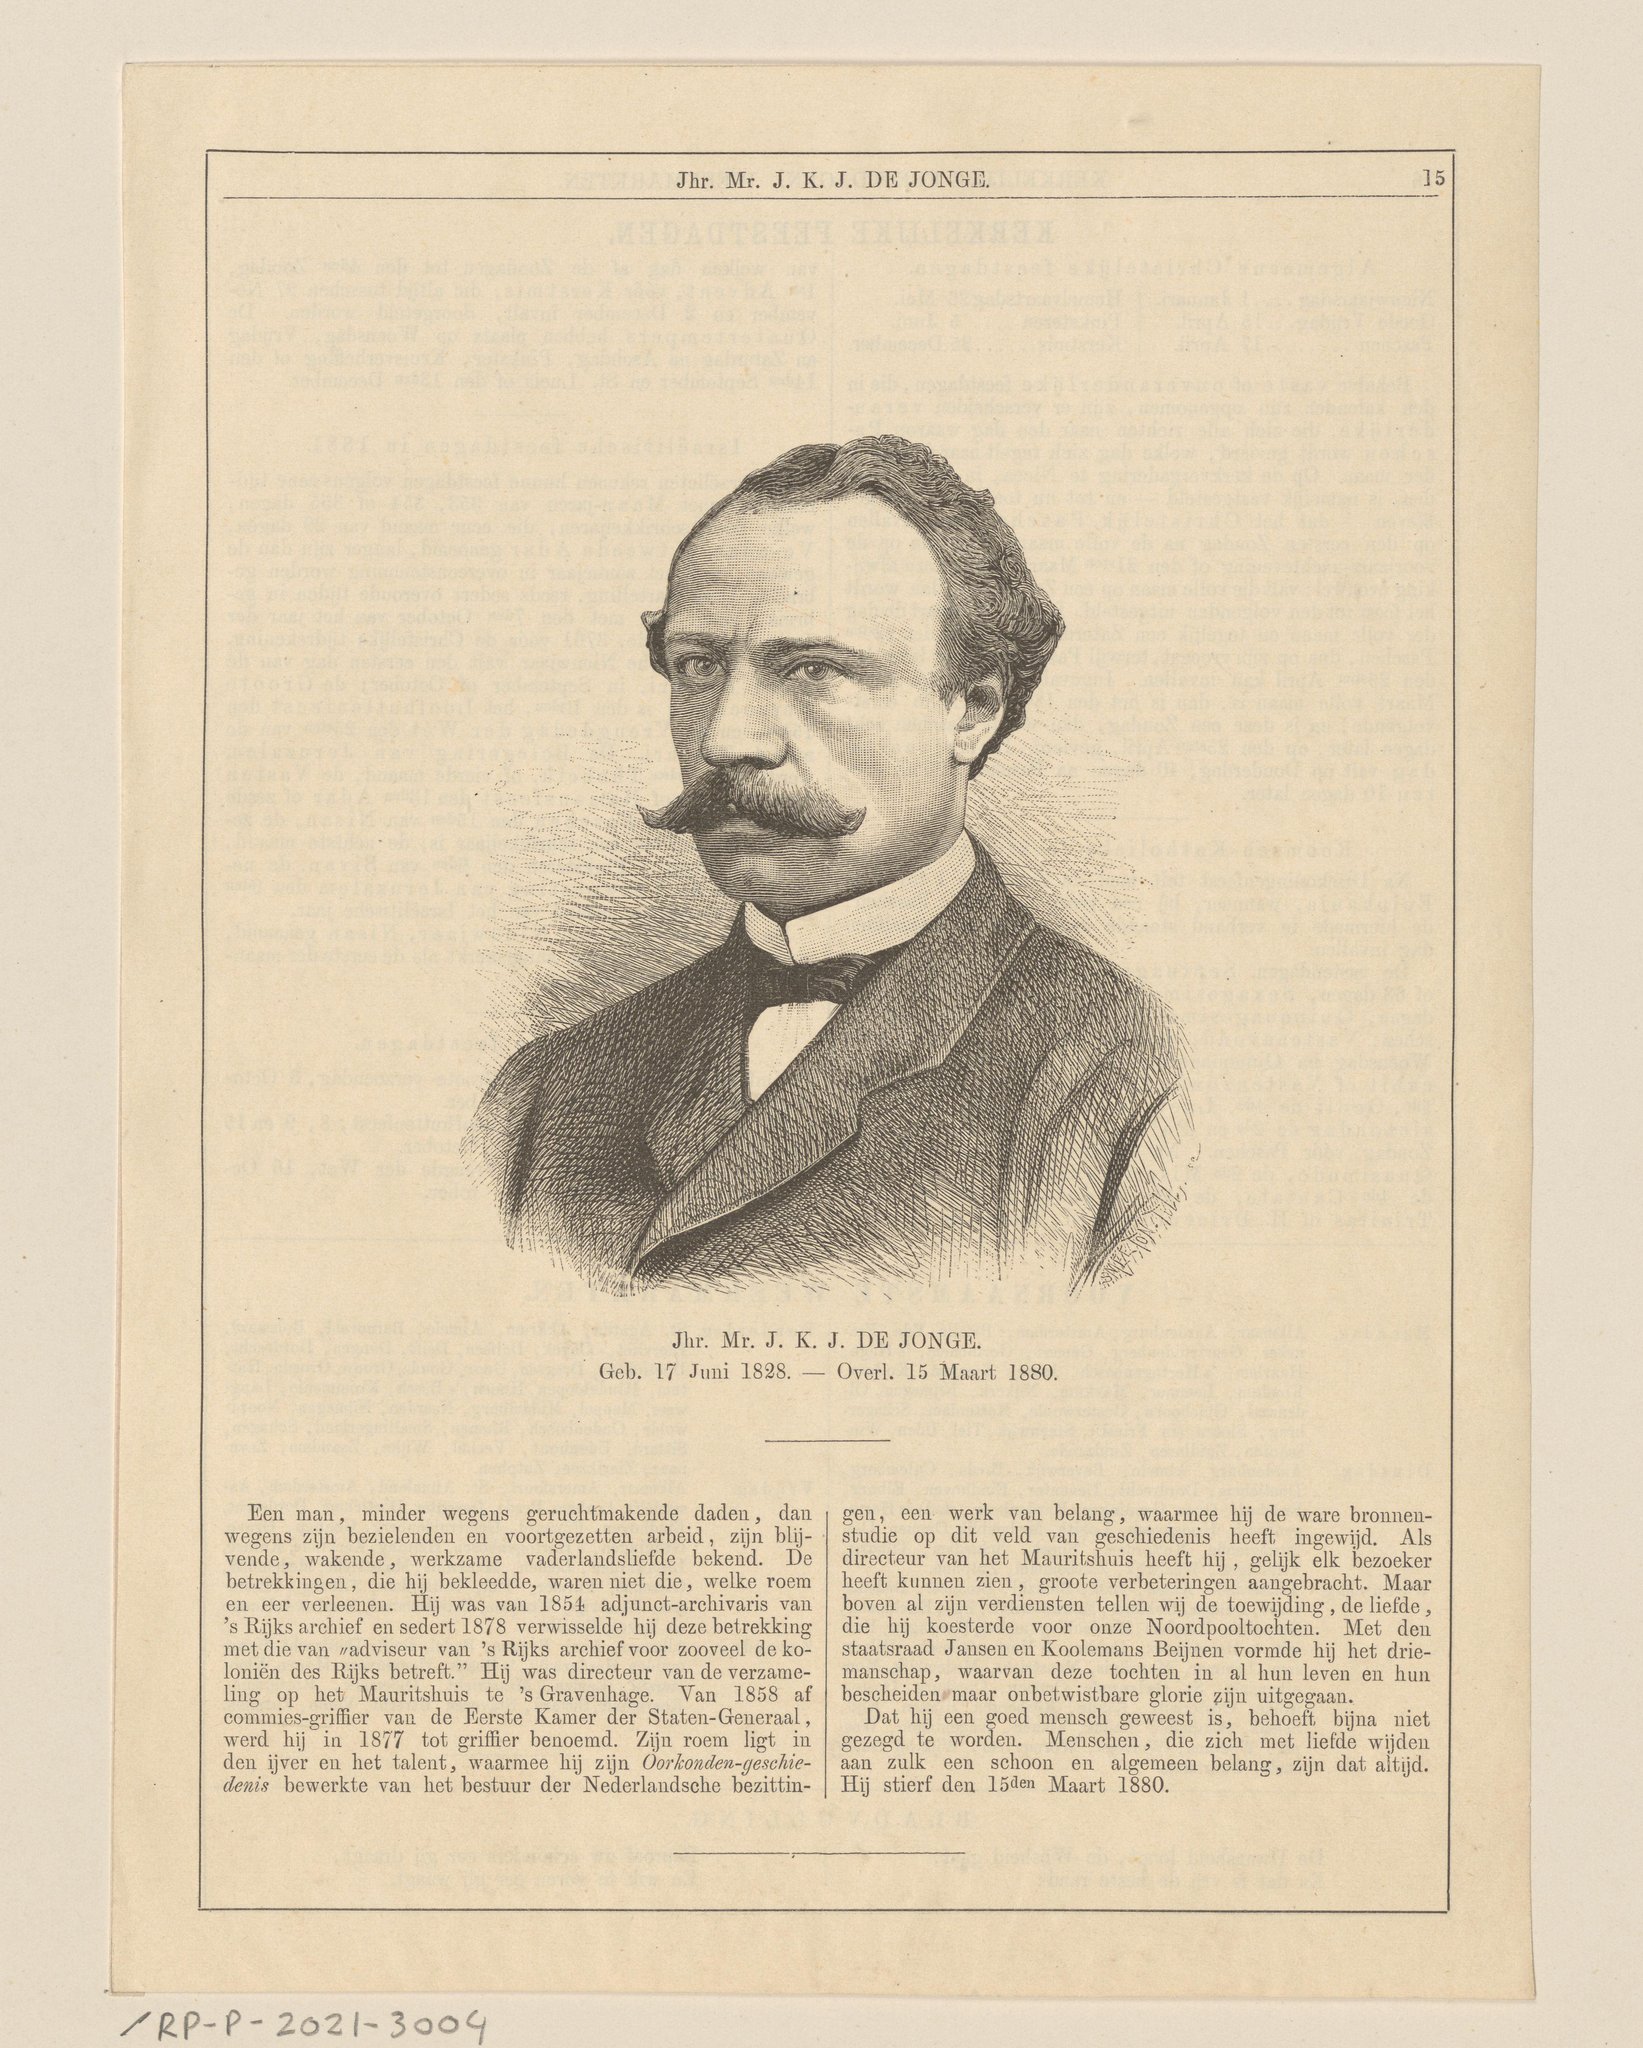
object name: print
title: Portret van Jan Karel Jacob de Jonge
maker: hermanus diedericus tjeenk willink (1843-1917)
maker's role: publisher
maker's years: 1843-1917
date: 1881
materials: paper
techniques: letterpress printing, engraving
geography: haarlem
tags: the hague, print maker, draughtsman, jan karel jacob de jonge, historical persons, politician, e.g. party leader, portrait, self-portrait of artist